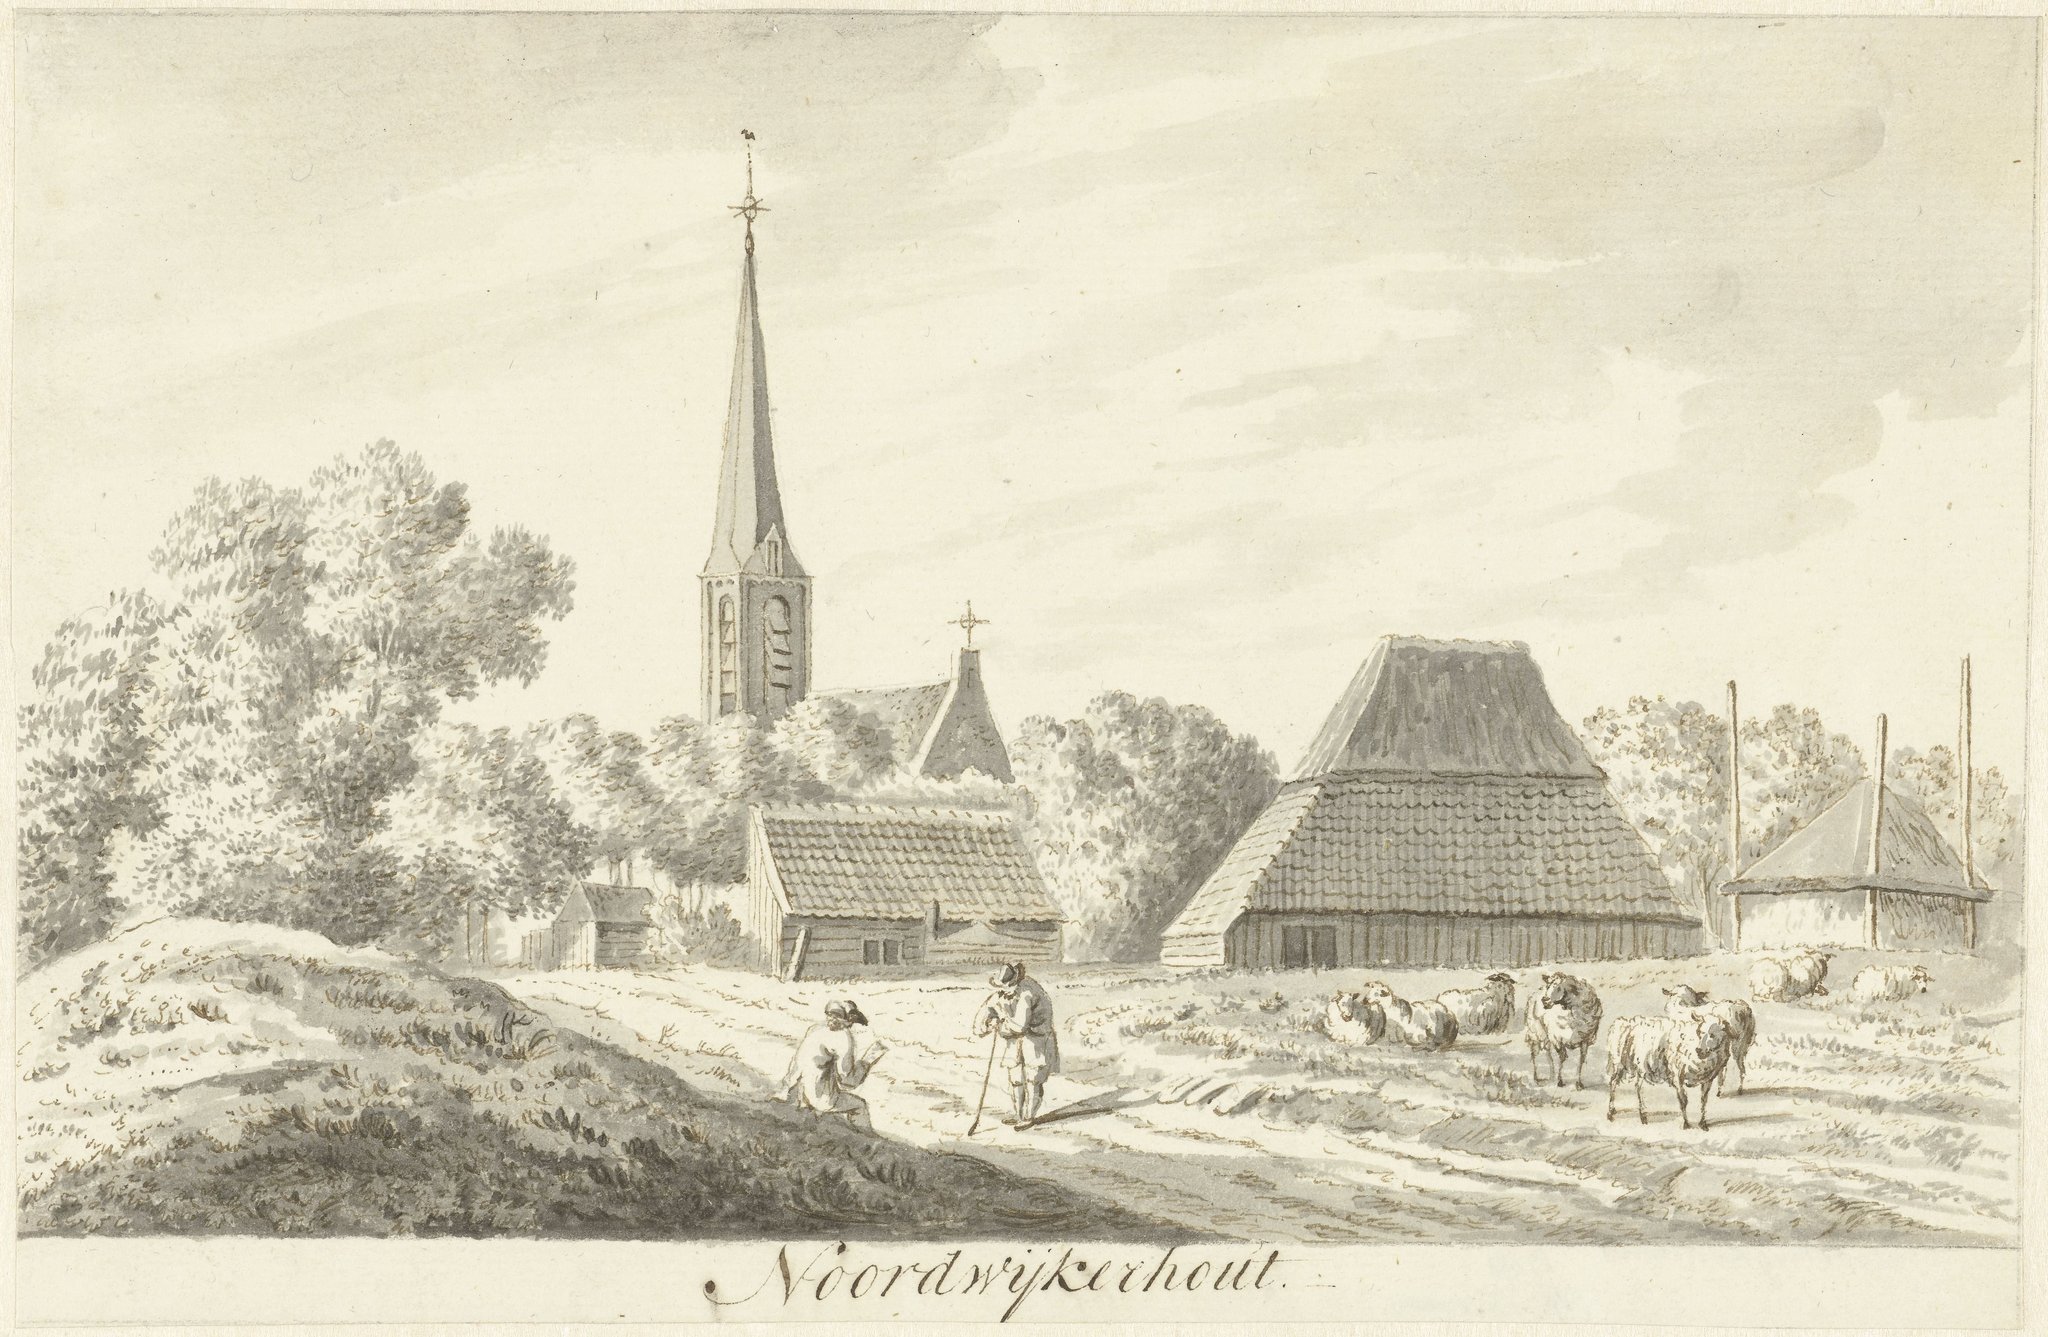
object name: drawing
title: Gezicht op het dorp Noordwijkerhout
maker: hendrik tavenier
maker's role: draughtsman, print maker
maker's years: 1734-1807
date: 1786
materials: ink, paper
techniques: brush, pen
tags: village, farm (building)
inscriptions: inscription: ‘Noortwykerhout 1786 / H: Tavenier’